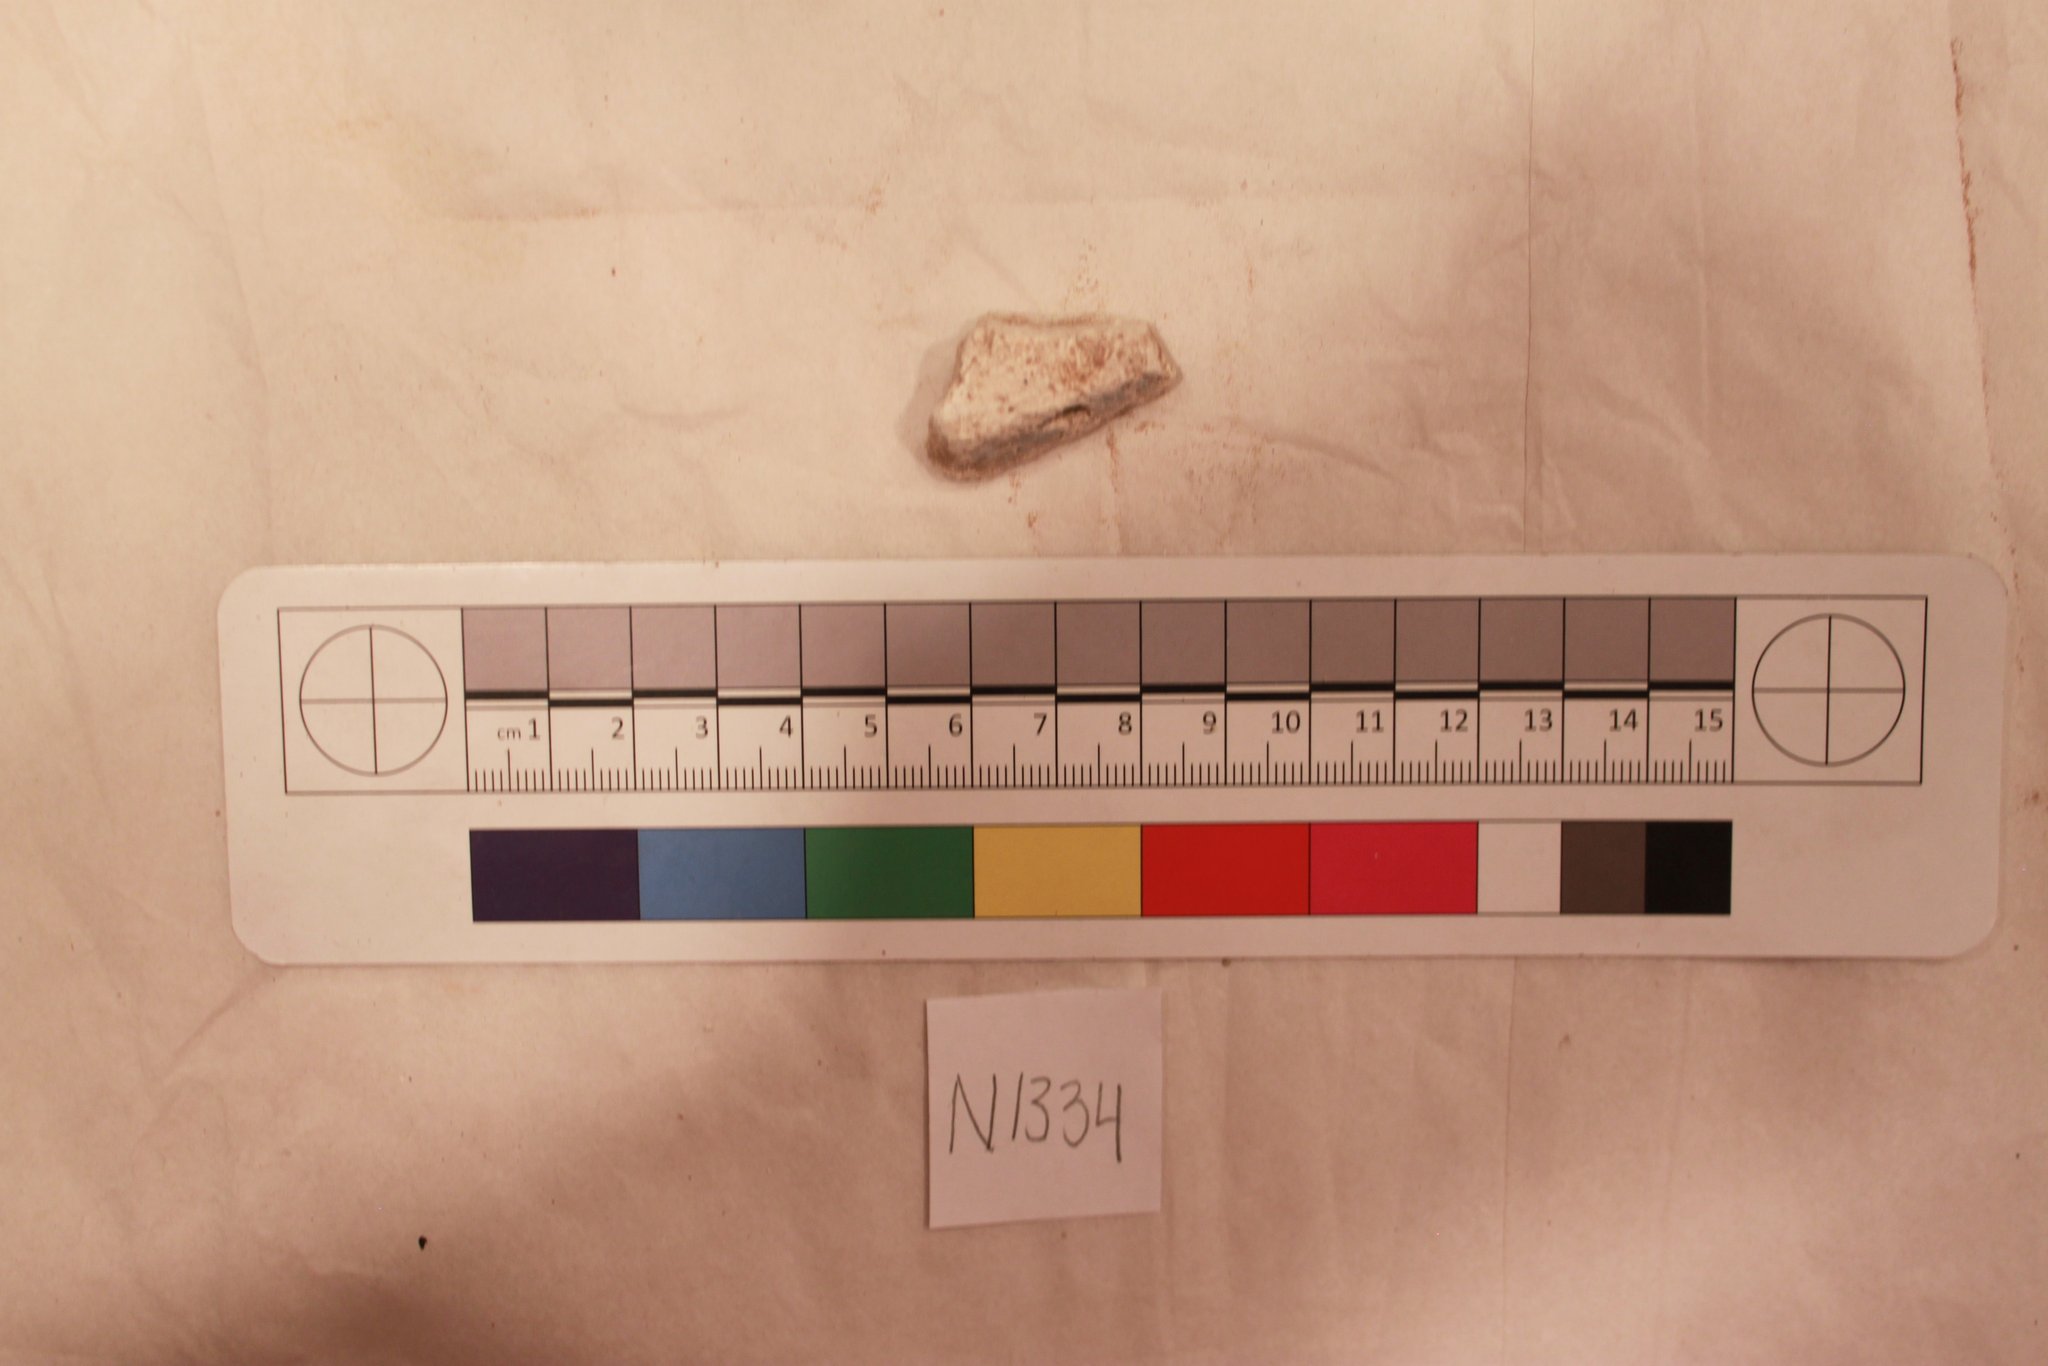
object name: fragment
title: Stucco Fragment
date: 701-1200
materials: plaster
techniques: carving, painting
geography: iran